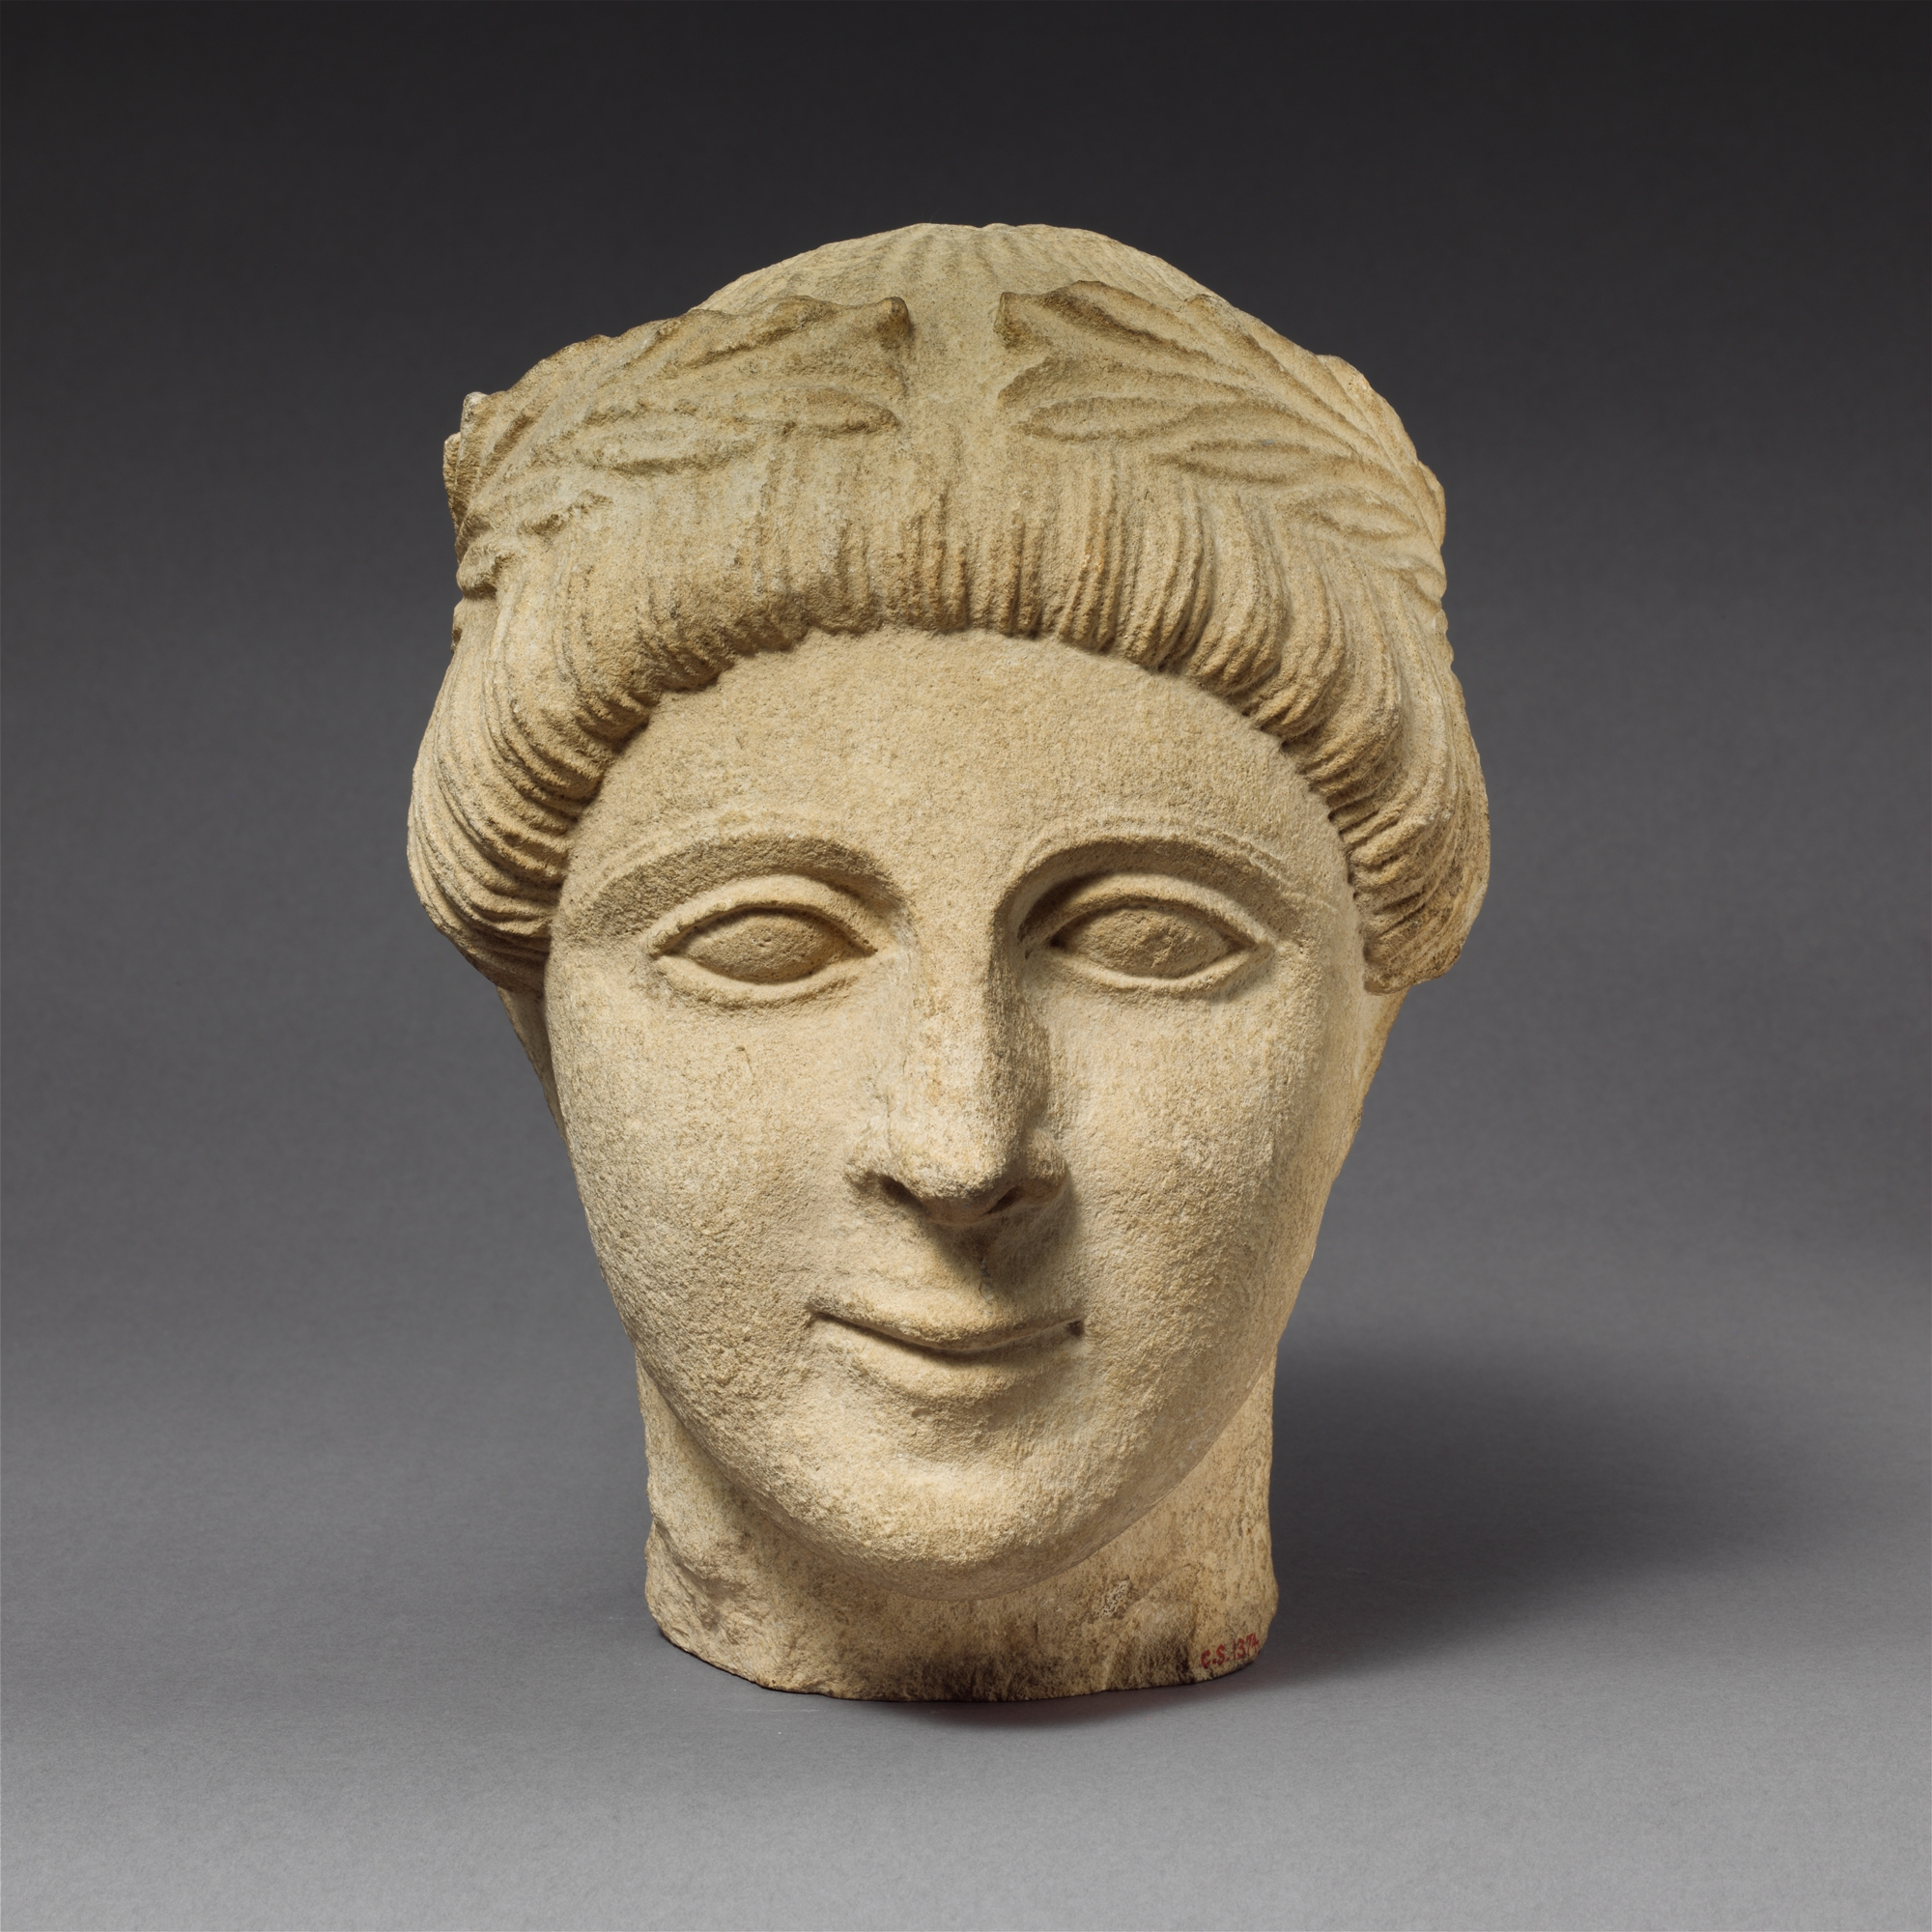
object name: head of a male votary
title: Limestone head of a beardless male votary with a wreath of leaves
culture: cypriot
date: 450-426 BCE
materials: limestone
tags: heads,men,leaves,wreaths